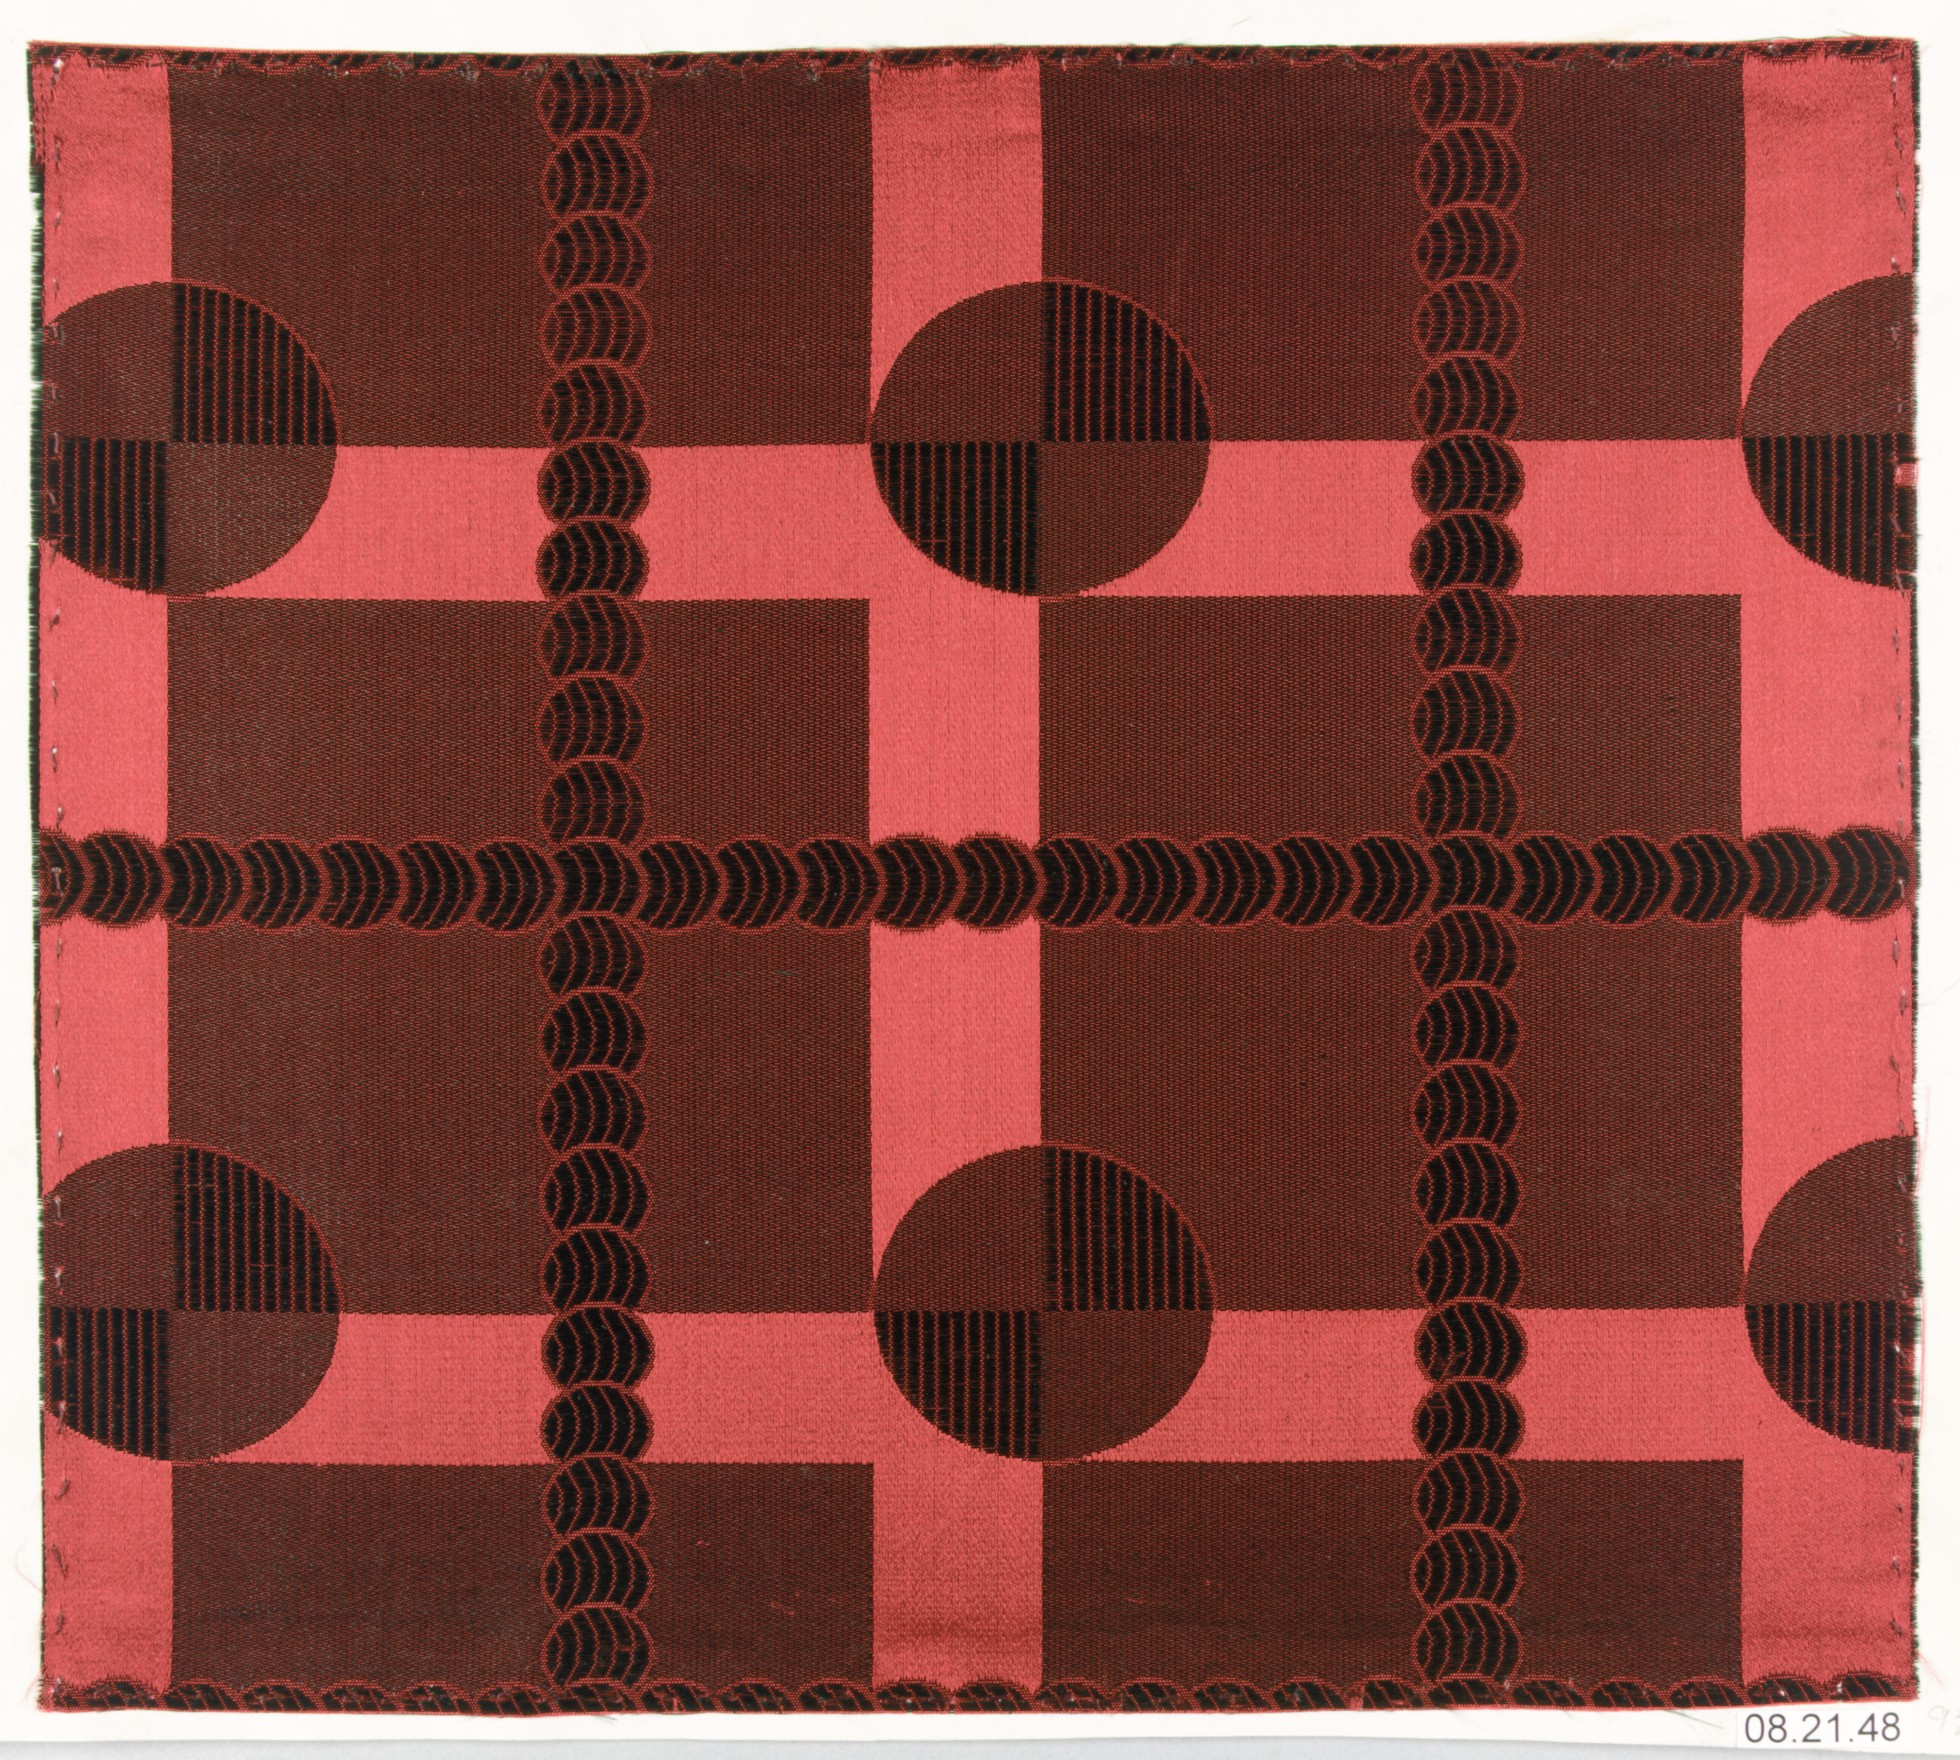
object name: textile sample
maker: Anonymous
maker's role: designer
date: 1900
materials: silk